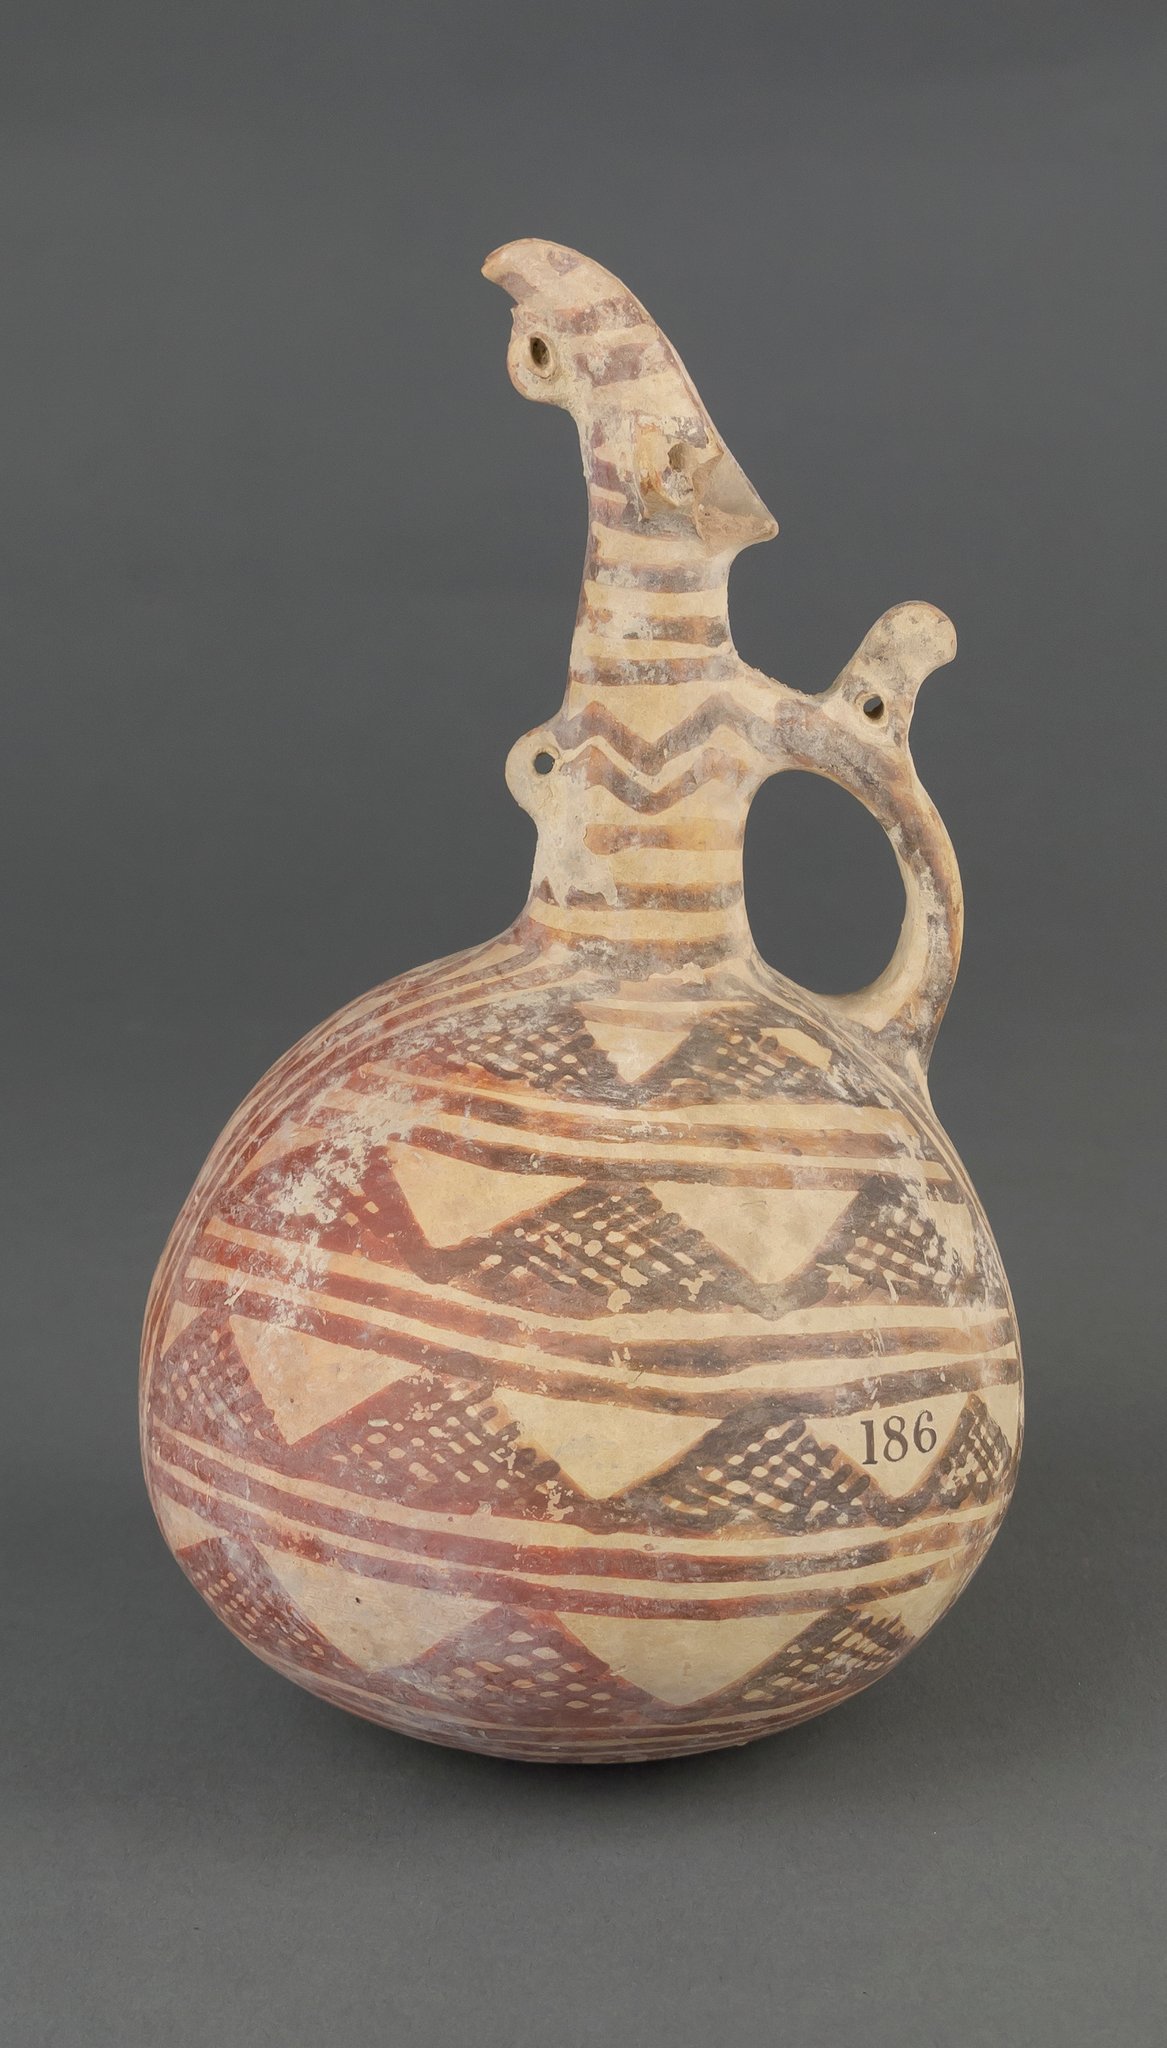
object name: jug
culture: cypriot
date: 3200-1050 BCE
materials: terracotta